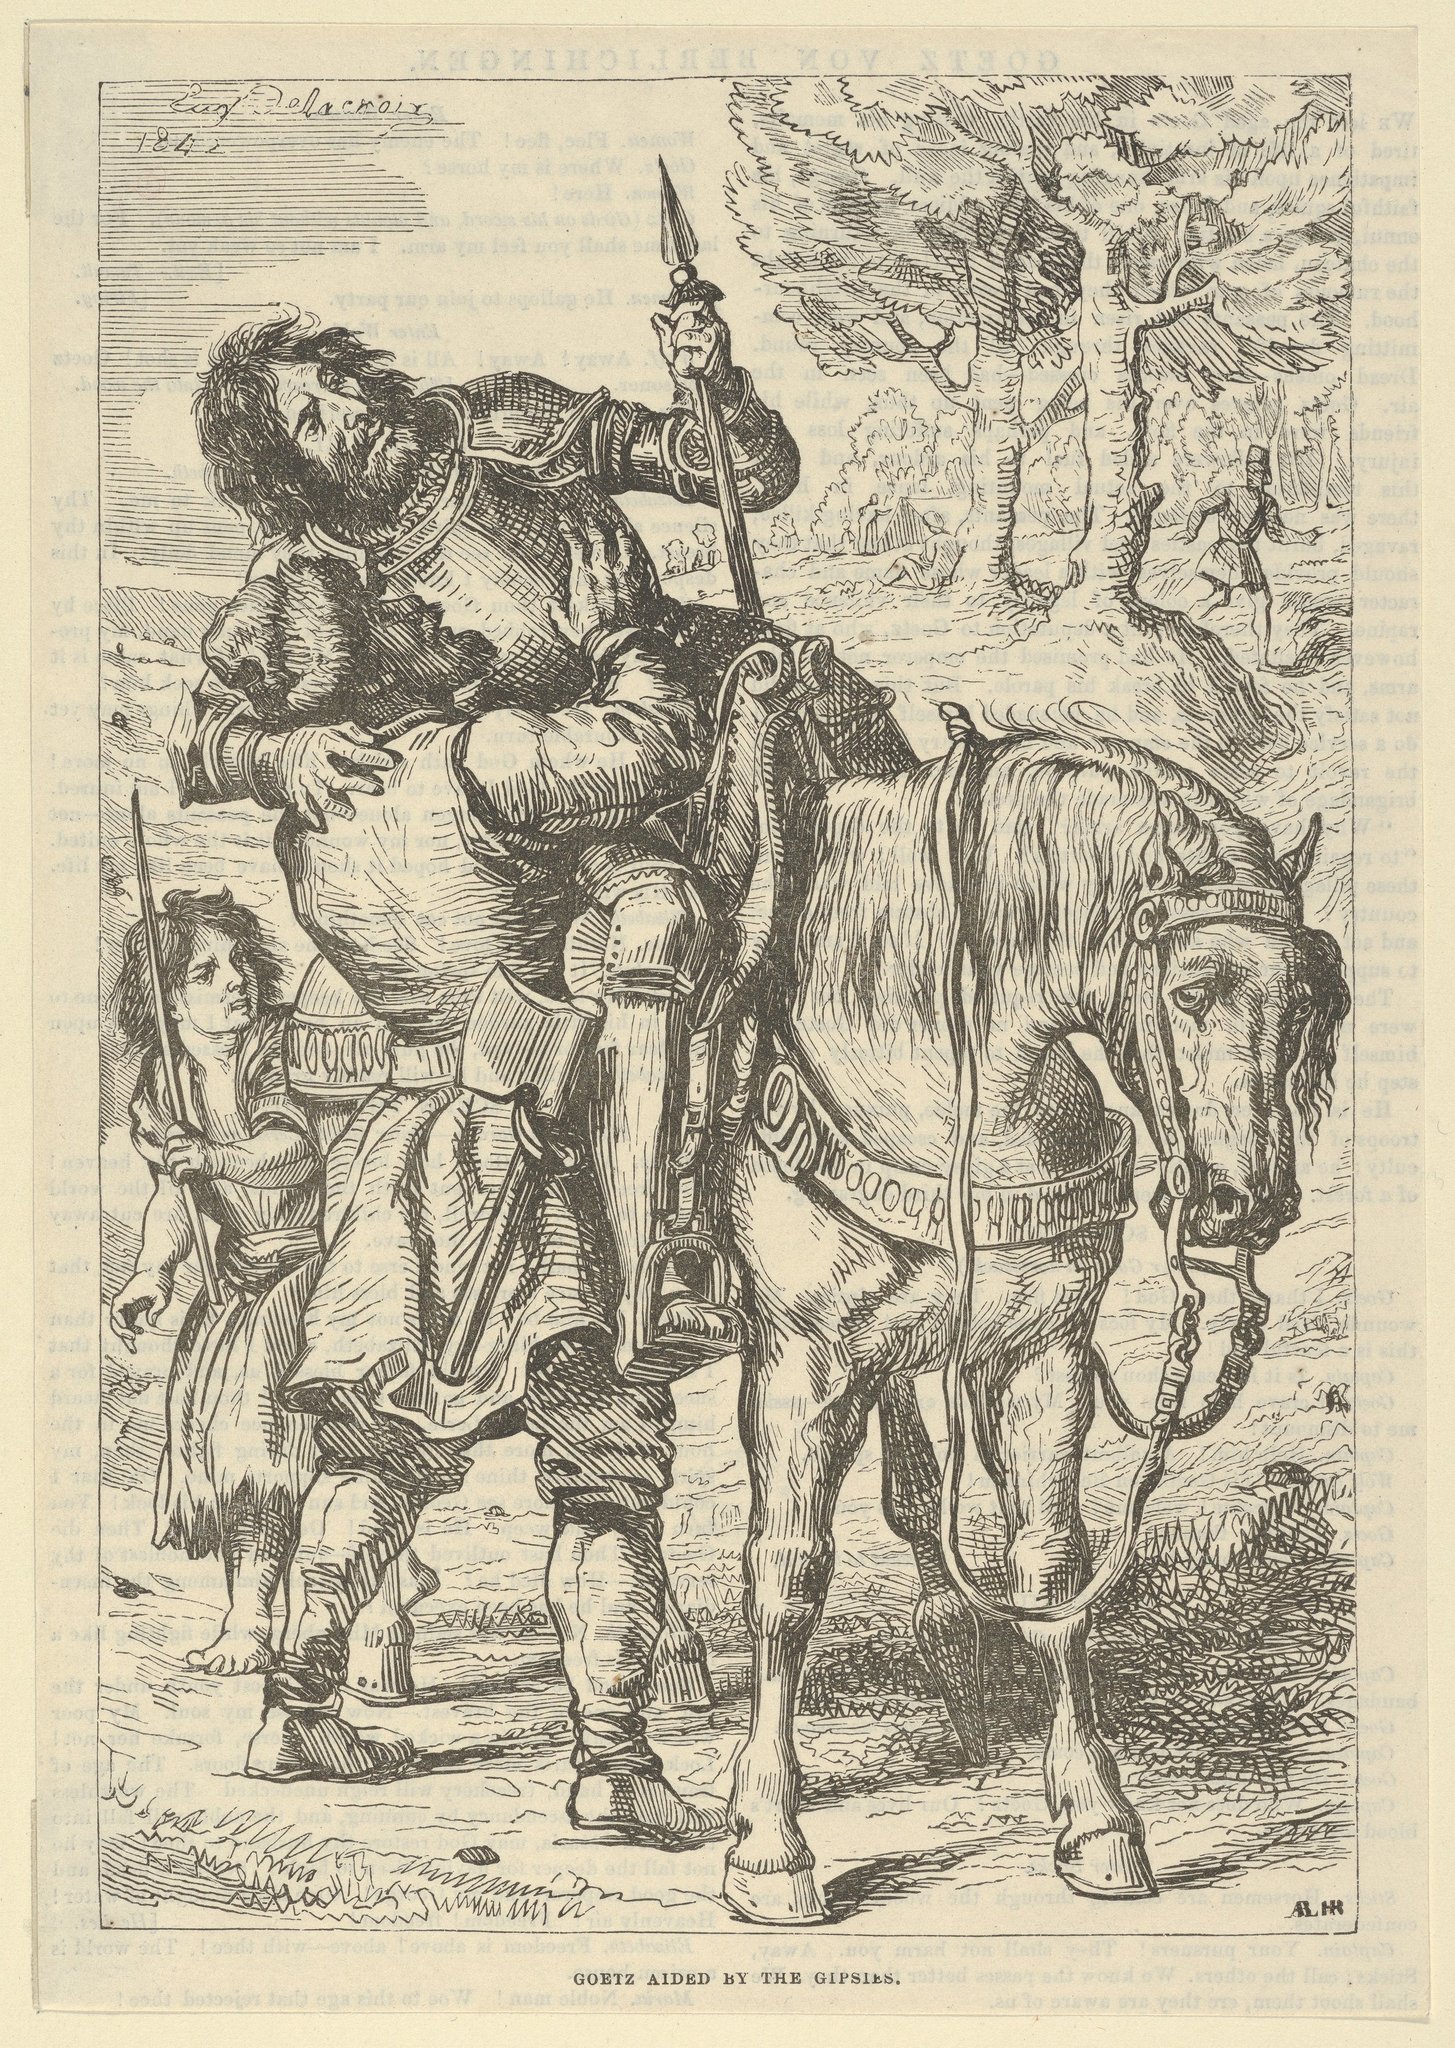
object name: print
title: Goetz Aided by the Gypsies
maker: eugène delacroix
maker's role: artist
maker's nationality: french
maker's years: 1798-1863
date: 1845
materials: paper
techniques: engraving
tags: spears,girls,men,horses,axes